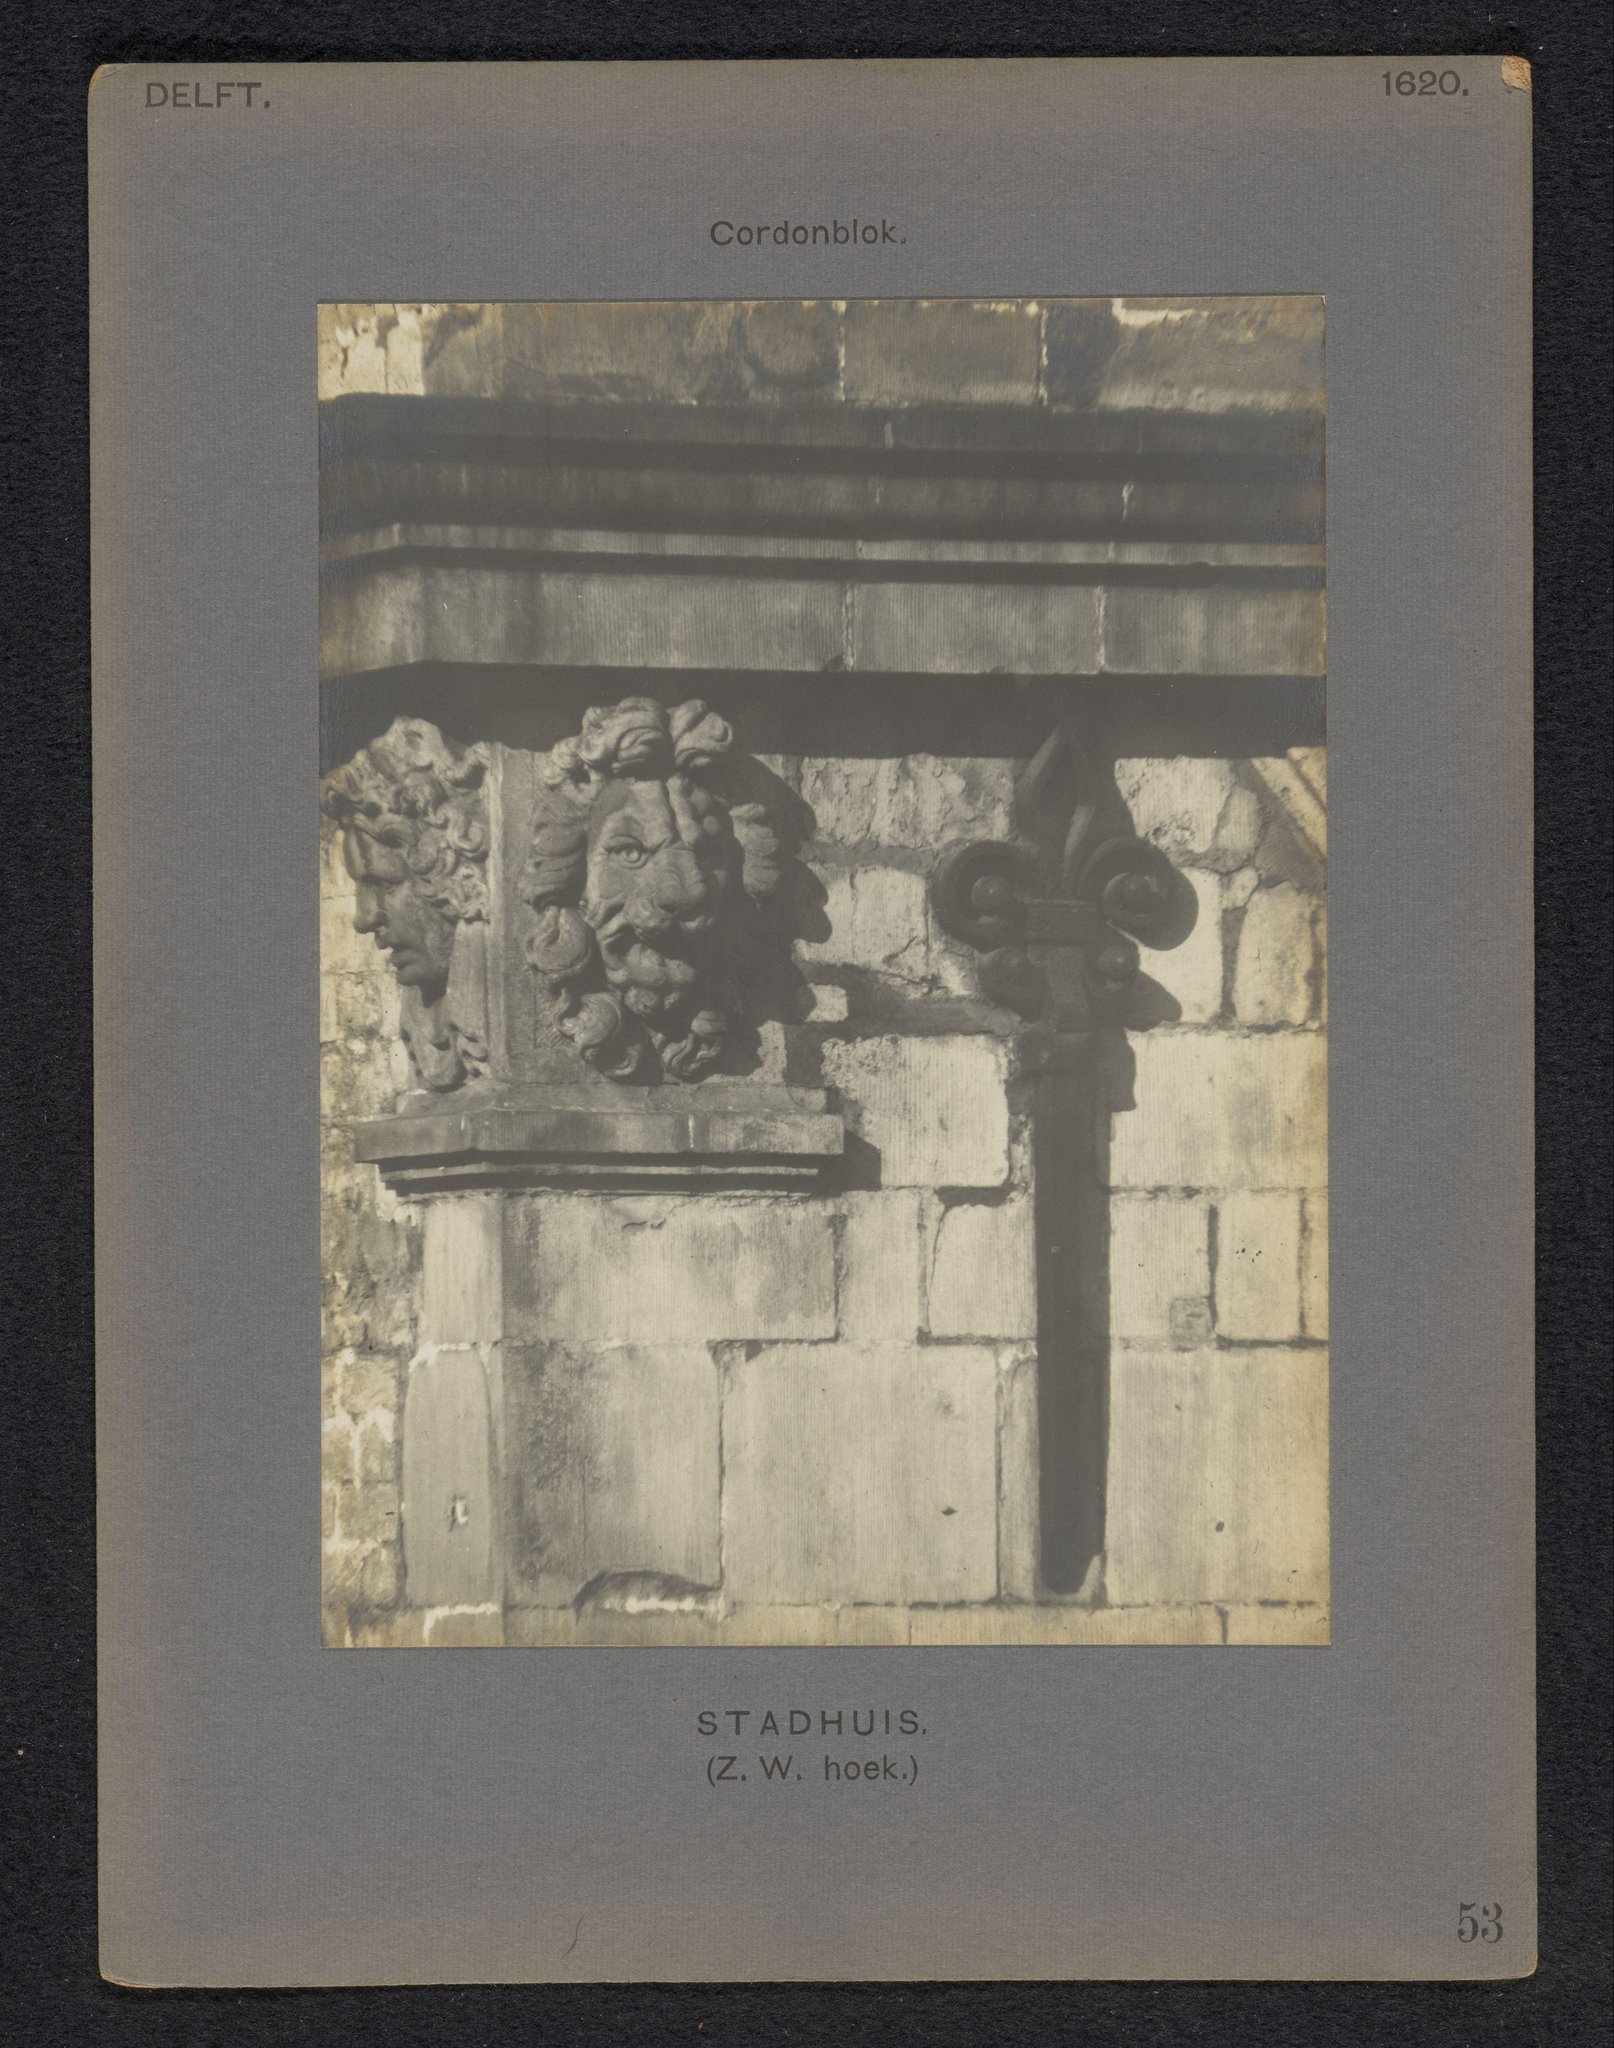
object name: photograph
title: Hoekstenen van het stadhuis in Delft, gedecoreerd met een leeuwenkop en een mensenhoofd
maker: Anonymous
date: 1900-1904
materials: cardboard, photographic support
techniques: gelatin silver print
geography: delft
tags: lion's head ~ ornament, townhall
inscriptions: inscription: ‘Delft. 1620.’, inscription: ‘Het recht van reproductie dezer photo's wordt door den Uitgever voorbehouden.’, number: ‘53’